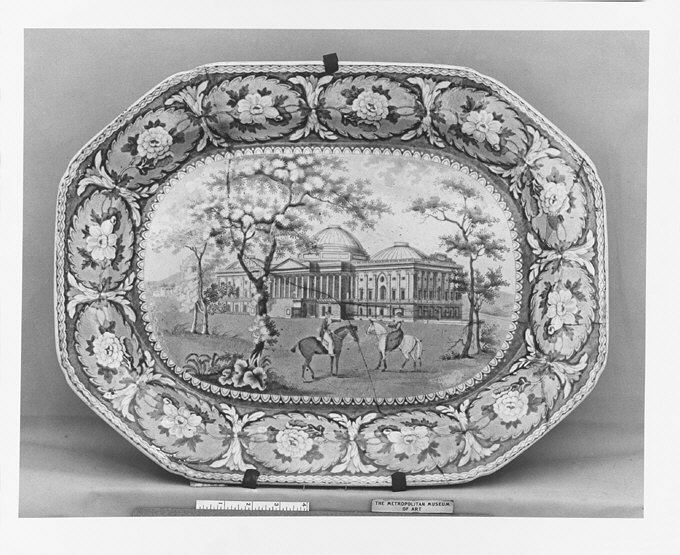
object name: platter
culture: british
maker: john & william ridgway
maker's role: maker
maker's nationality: british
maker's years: 1809-1830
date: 1830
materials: earthenware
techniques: transfer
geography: england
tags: buildings,horses,flowers